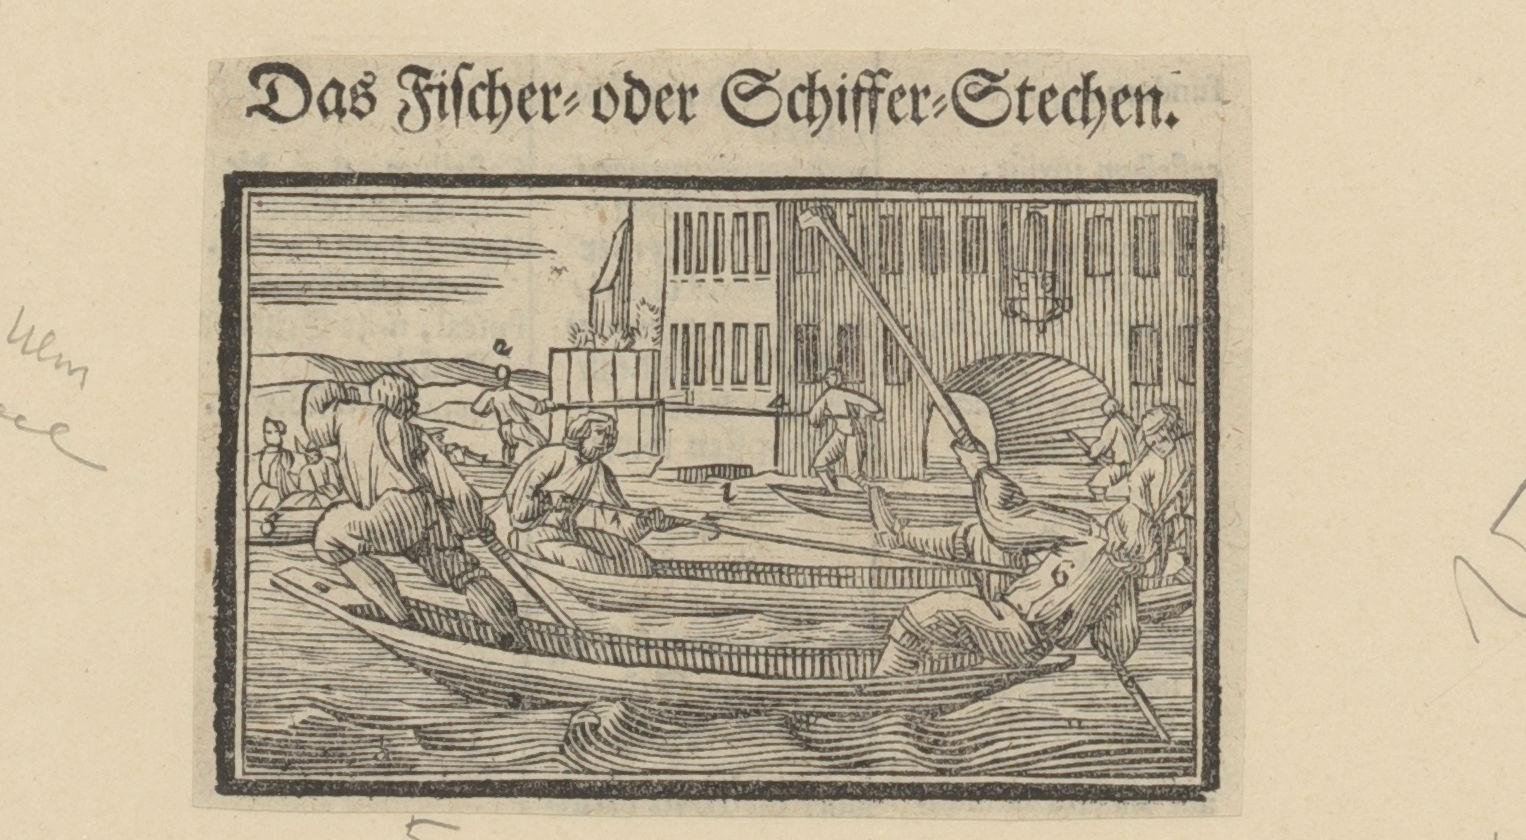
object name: book illustration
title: Wedstrijd met door bomen voortbewogen schuiten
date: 1719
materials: paper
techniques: letterpress printing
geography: nuremberg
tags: rowing facing forward, pushing, handicrafts, craftsman at work, rowing-boat, canoe, etc.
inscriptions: stamp, collector's mark: Lugt 1641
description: Op het water een wedstijd tussen open, platte schuiten, elk bemand door twee mannen, die de boten met lange bomen voortbewegen en proberen elkaar in het water te duwen. Onderwerpsrubrieken binnen de Atlas Zeden en Gewoonten: Handel, Nijverheid en Verkeer, Beroep en bedrijf, Complete suites.